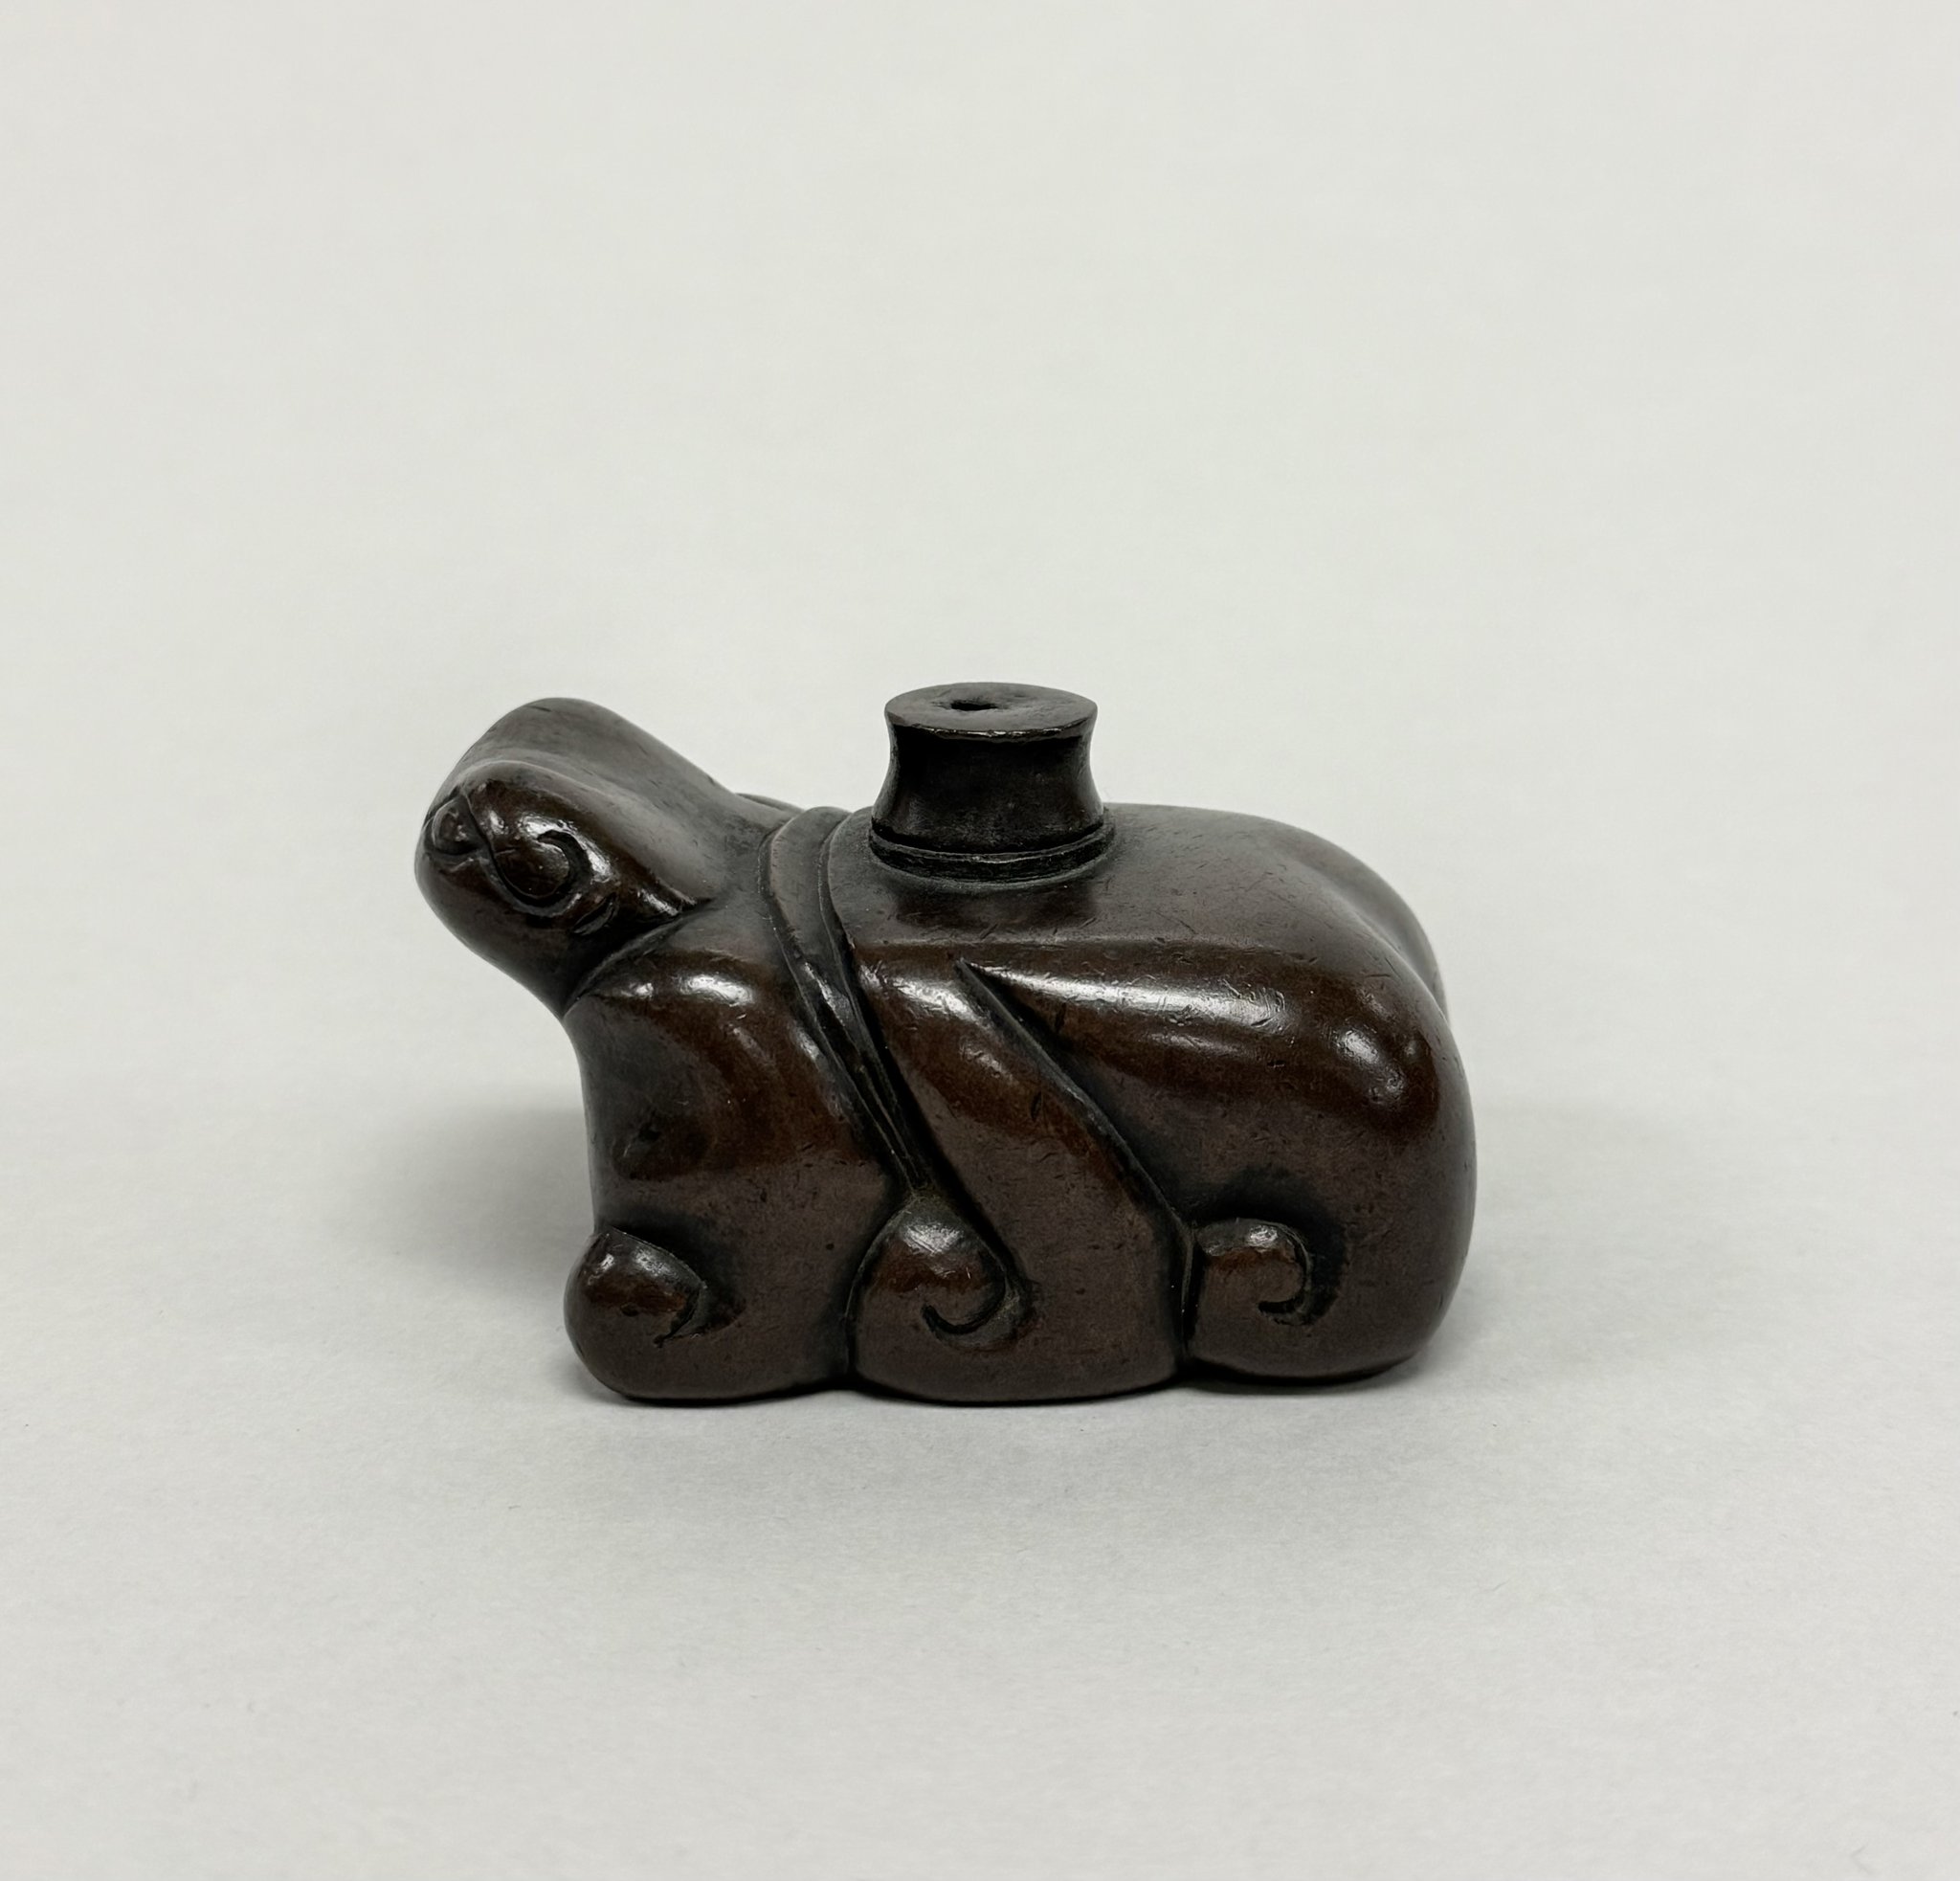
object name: vessel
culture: japanese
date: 1801-1900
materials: bronze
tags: animals